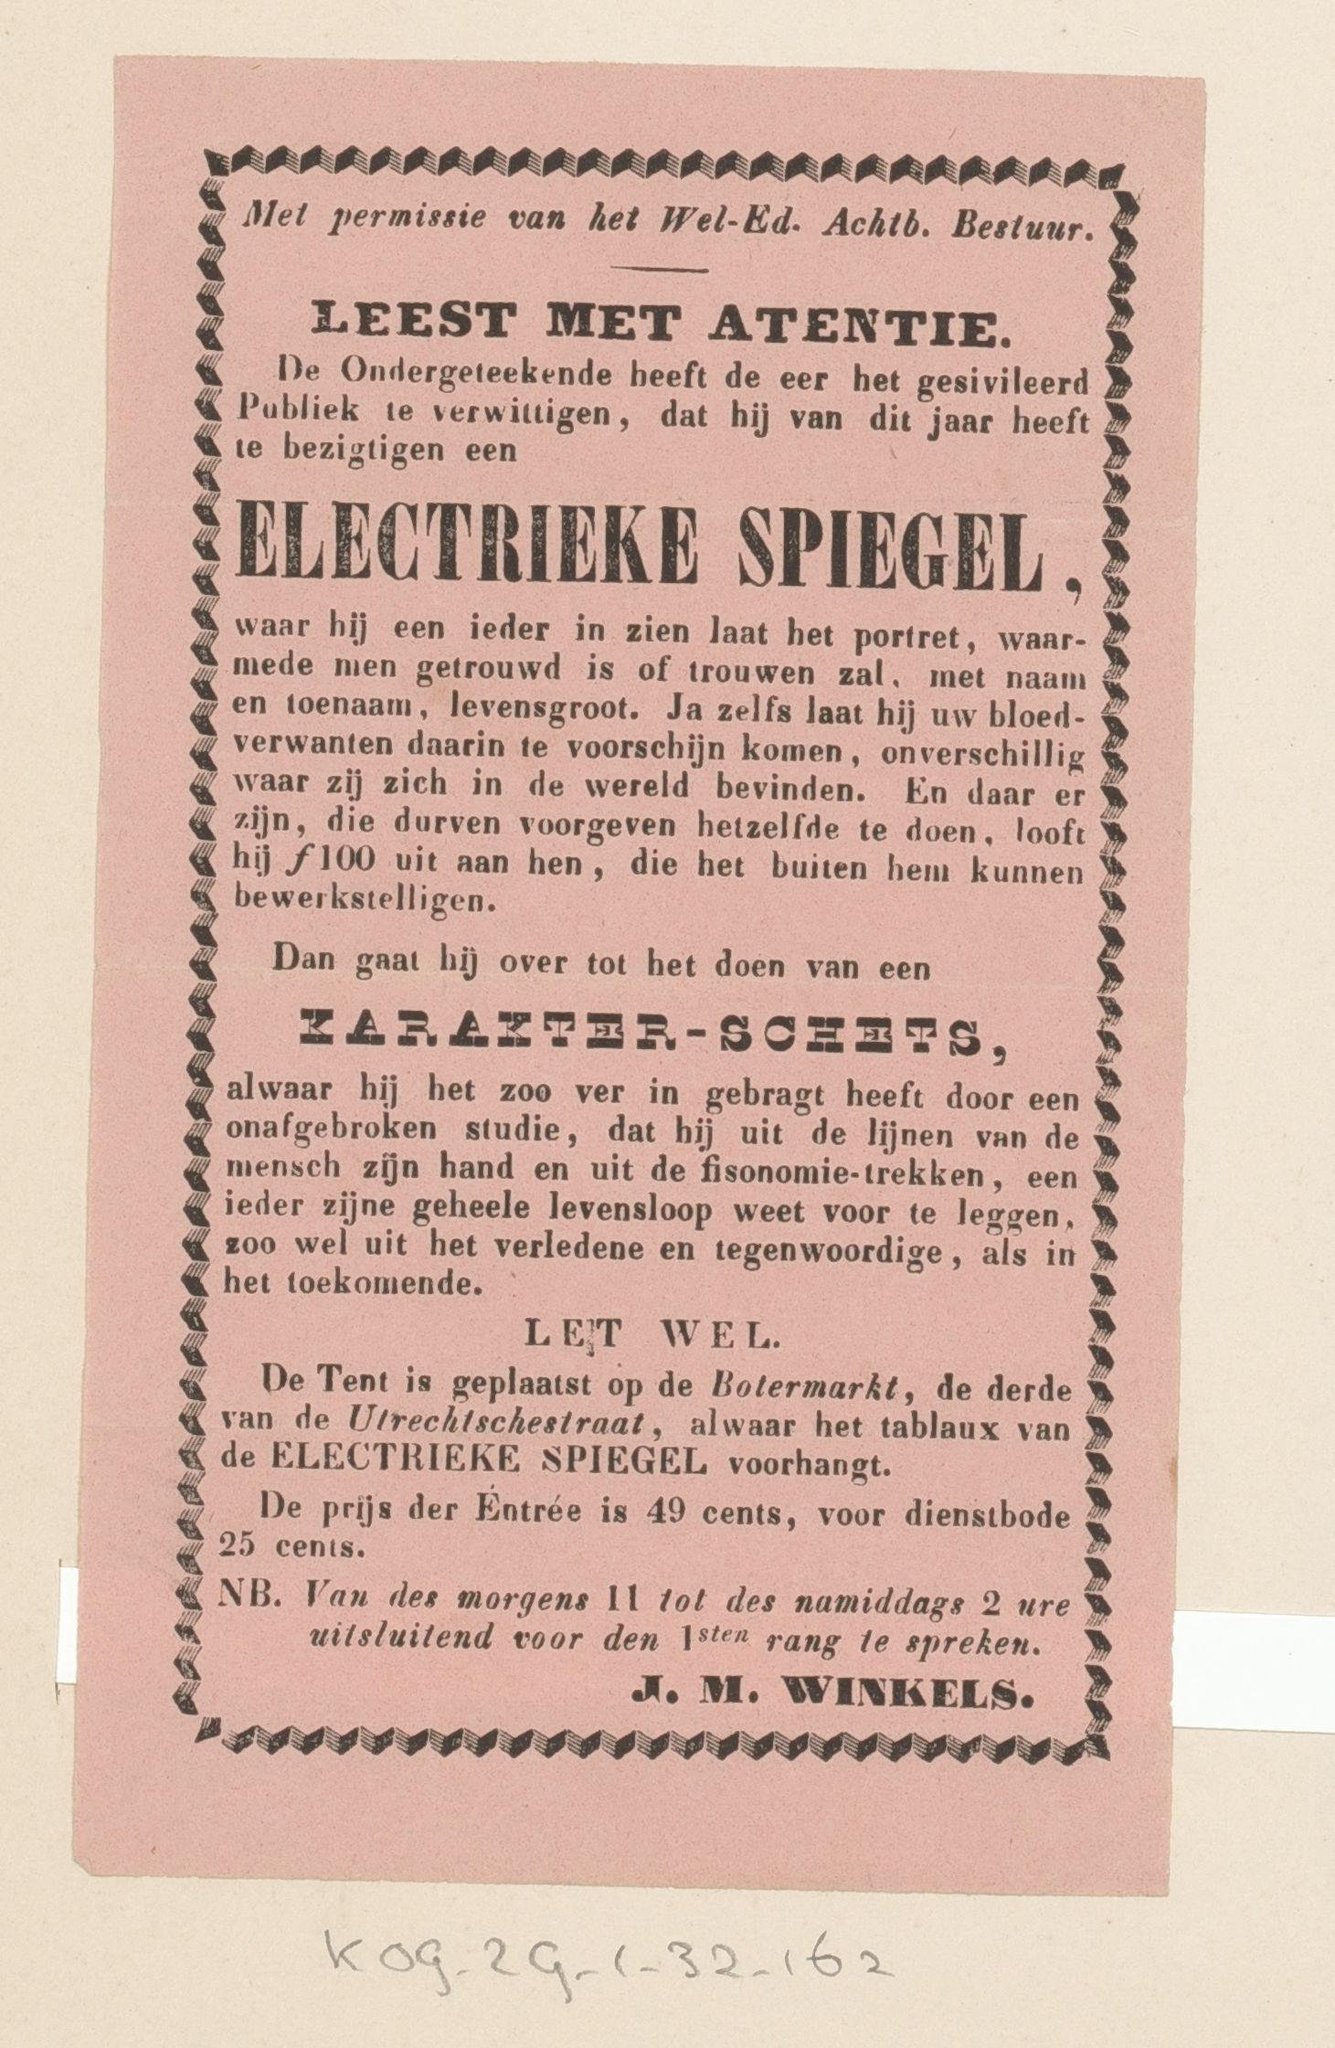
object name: text sheet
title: Leest met Atentie. De Ondergeteekende (...) heeft te bezigtigen een Electrieke Spiegel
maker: Anonymous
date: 1852-1857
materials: paper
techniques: letterpress printing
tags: illusionist, conjurer, juggler, 'legerdemain', fortune-teller ~ pleasure fair and circus, pleasure fair and circus, amsterdam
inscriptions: collector's mark, collector's mark: Lugt 1641